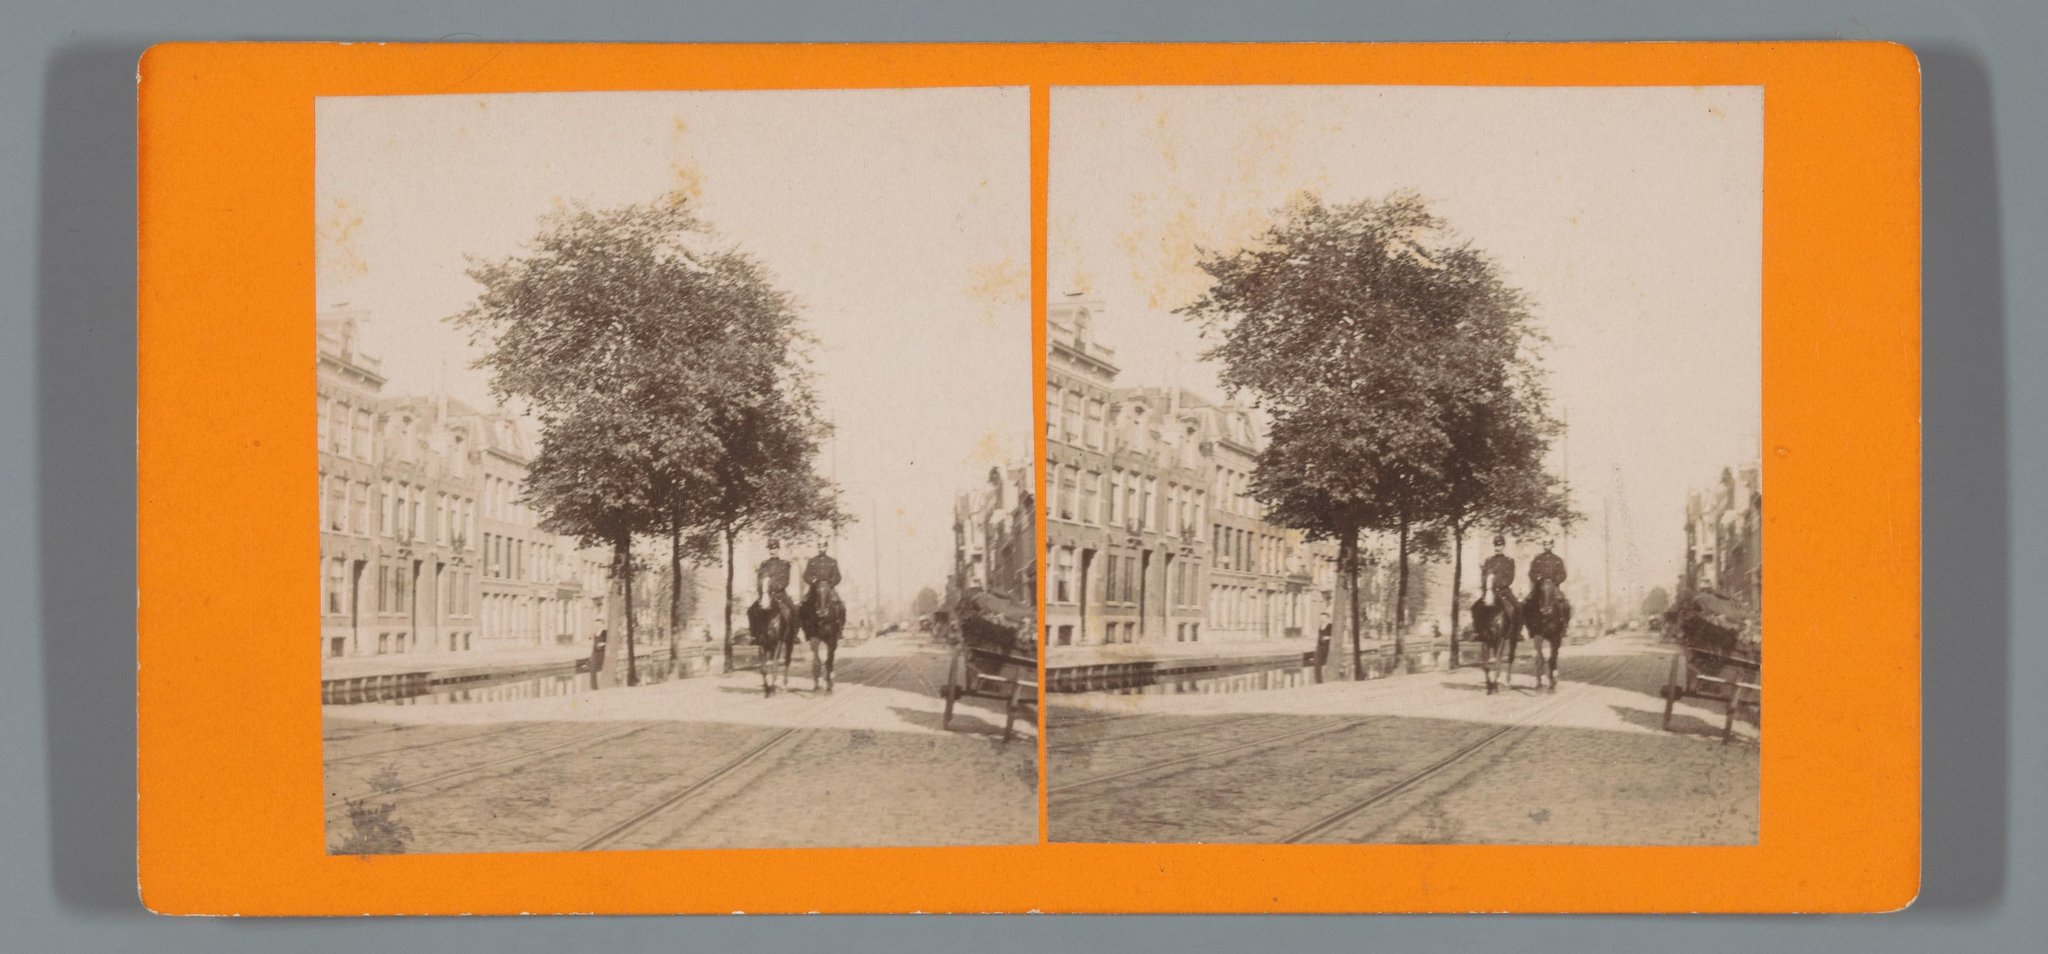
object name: stereograph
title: Twee agenten te paard rijden over de Overtoom voor de demping, Amsterdam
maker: Anonymous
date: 1880-1900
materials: cardboard, paper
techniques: albumen print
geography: amsterdam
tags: canals, waters (in city)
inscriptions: retailer's mark: ‘Gebr. Douwes/ Ateliers/ Warmoesstraat 73/ Amsterdam’, number: ‘186’, inscription: ‘Amsterdam/ Overtoom’